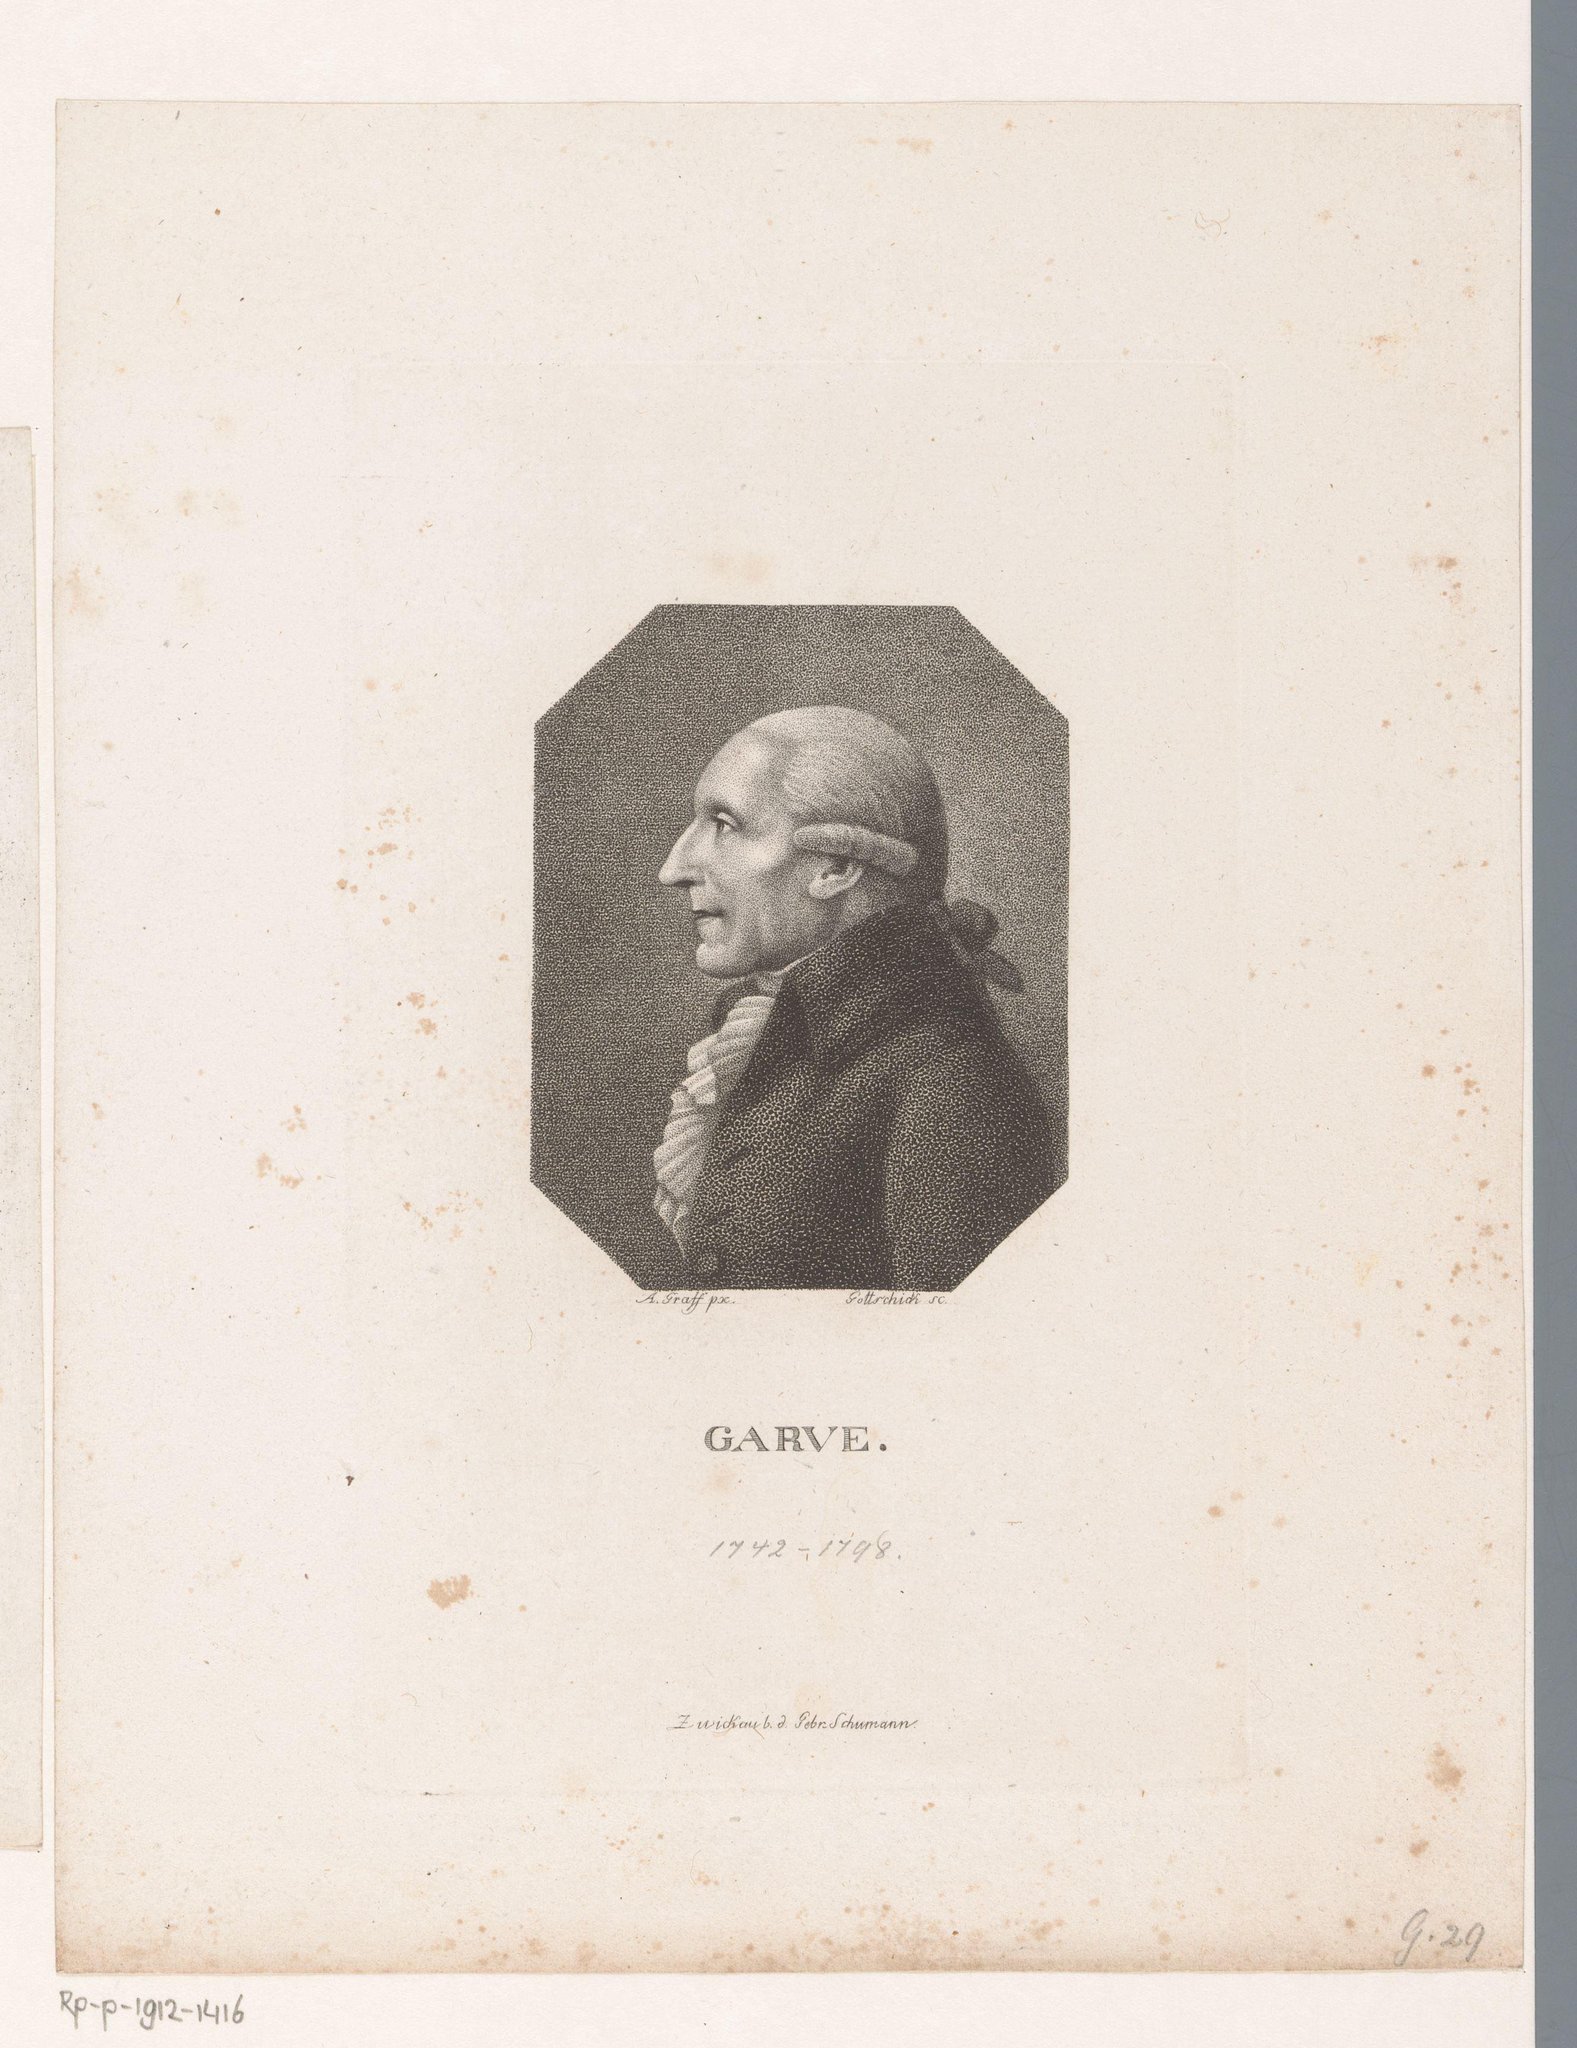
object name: print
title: Bildnisse der berühmtesten Menschen aller Völker und Zeiten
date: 1818-1832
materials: paper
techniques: stippling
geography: zwickau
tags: historical persons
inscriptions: collector's mark: Lugt 2228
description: Prent afkomstig uit: 'Bildnisse der berühmtesten Menschen aller Völker und Zeiten' van de gebroeders Schumann, uitgegeven in 1818-1832 te Zwickau.